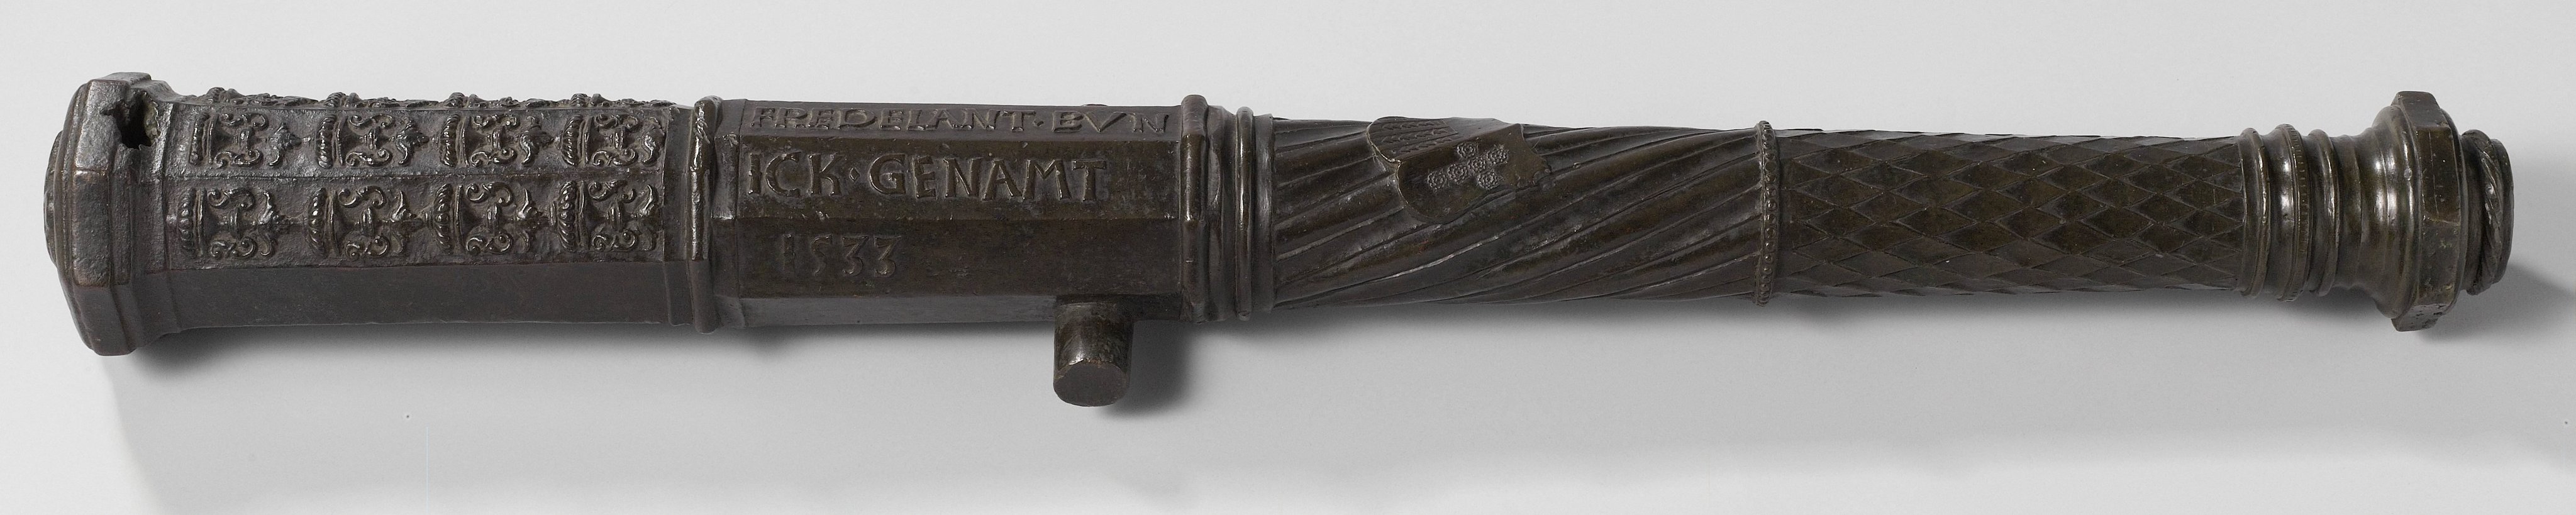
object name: cannon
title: The Cannon ‘Fredelant’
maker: willem tolhuys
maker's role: caster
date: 1533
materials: bronze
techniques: casting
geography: arnhem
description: This is the oldest known cannon inscribed with a Dutch text, which translates as: ‘Fredelant is my name’. On the barrel are the arms of the married couple Hendrik van Isendoorn à Blois and Sophia van Stommel. Hendrik owned Cannenburch Castle in Vaassen, where this little cannon stood until 1881. The decoration is in the style of the period (transition from Gothic to Renaissance), when the candlestick motifs would then have been considered very modern-looking.